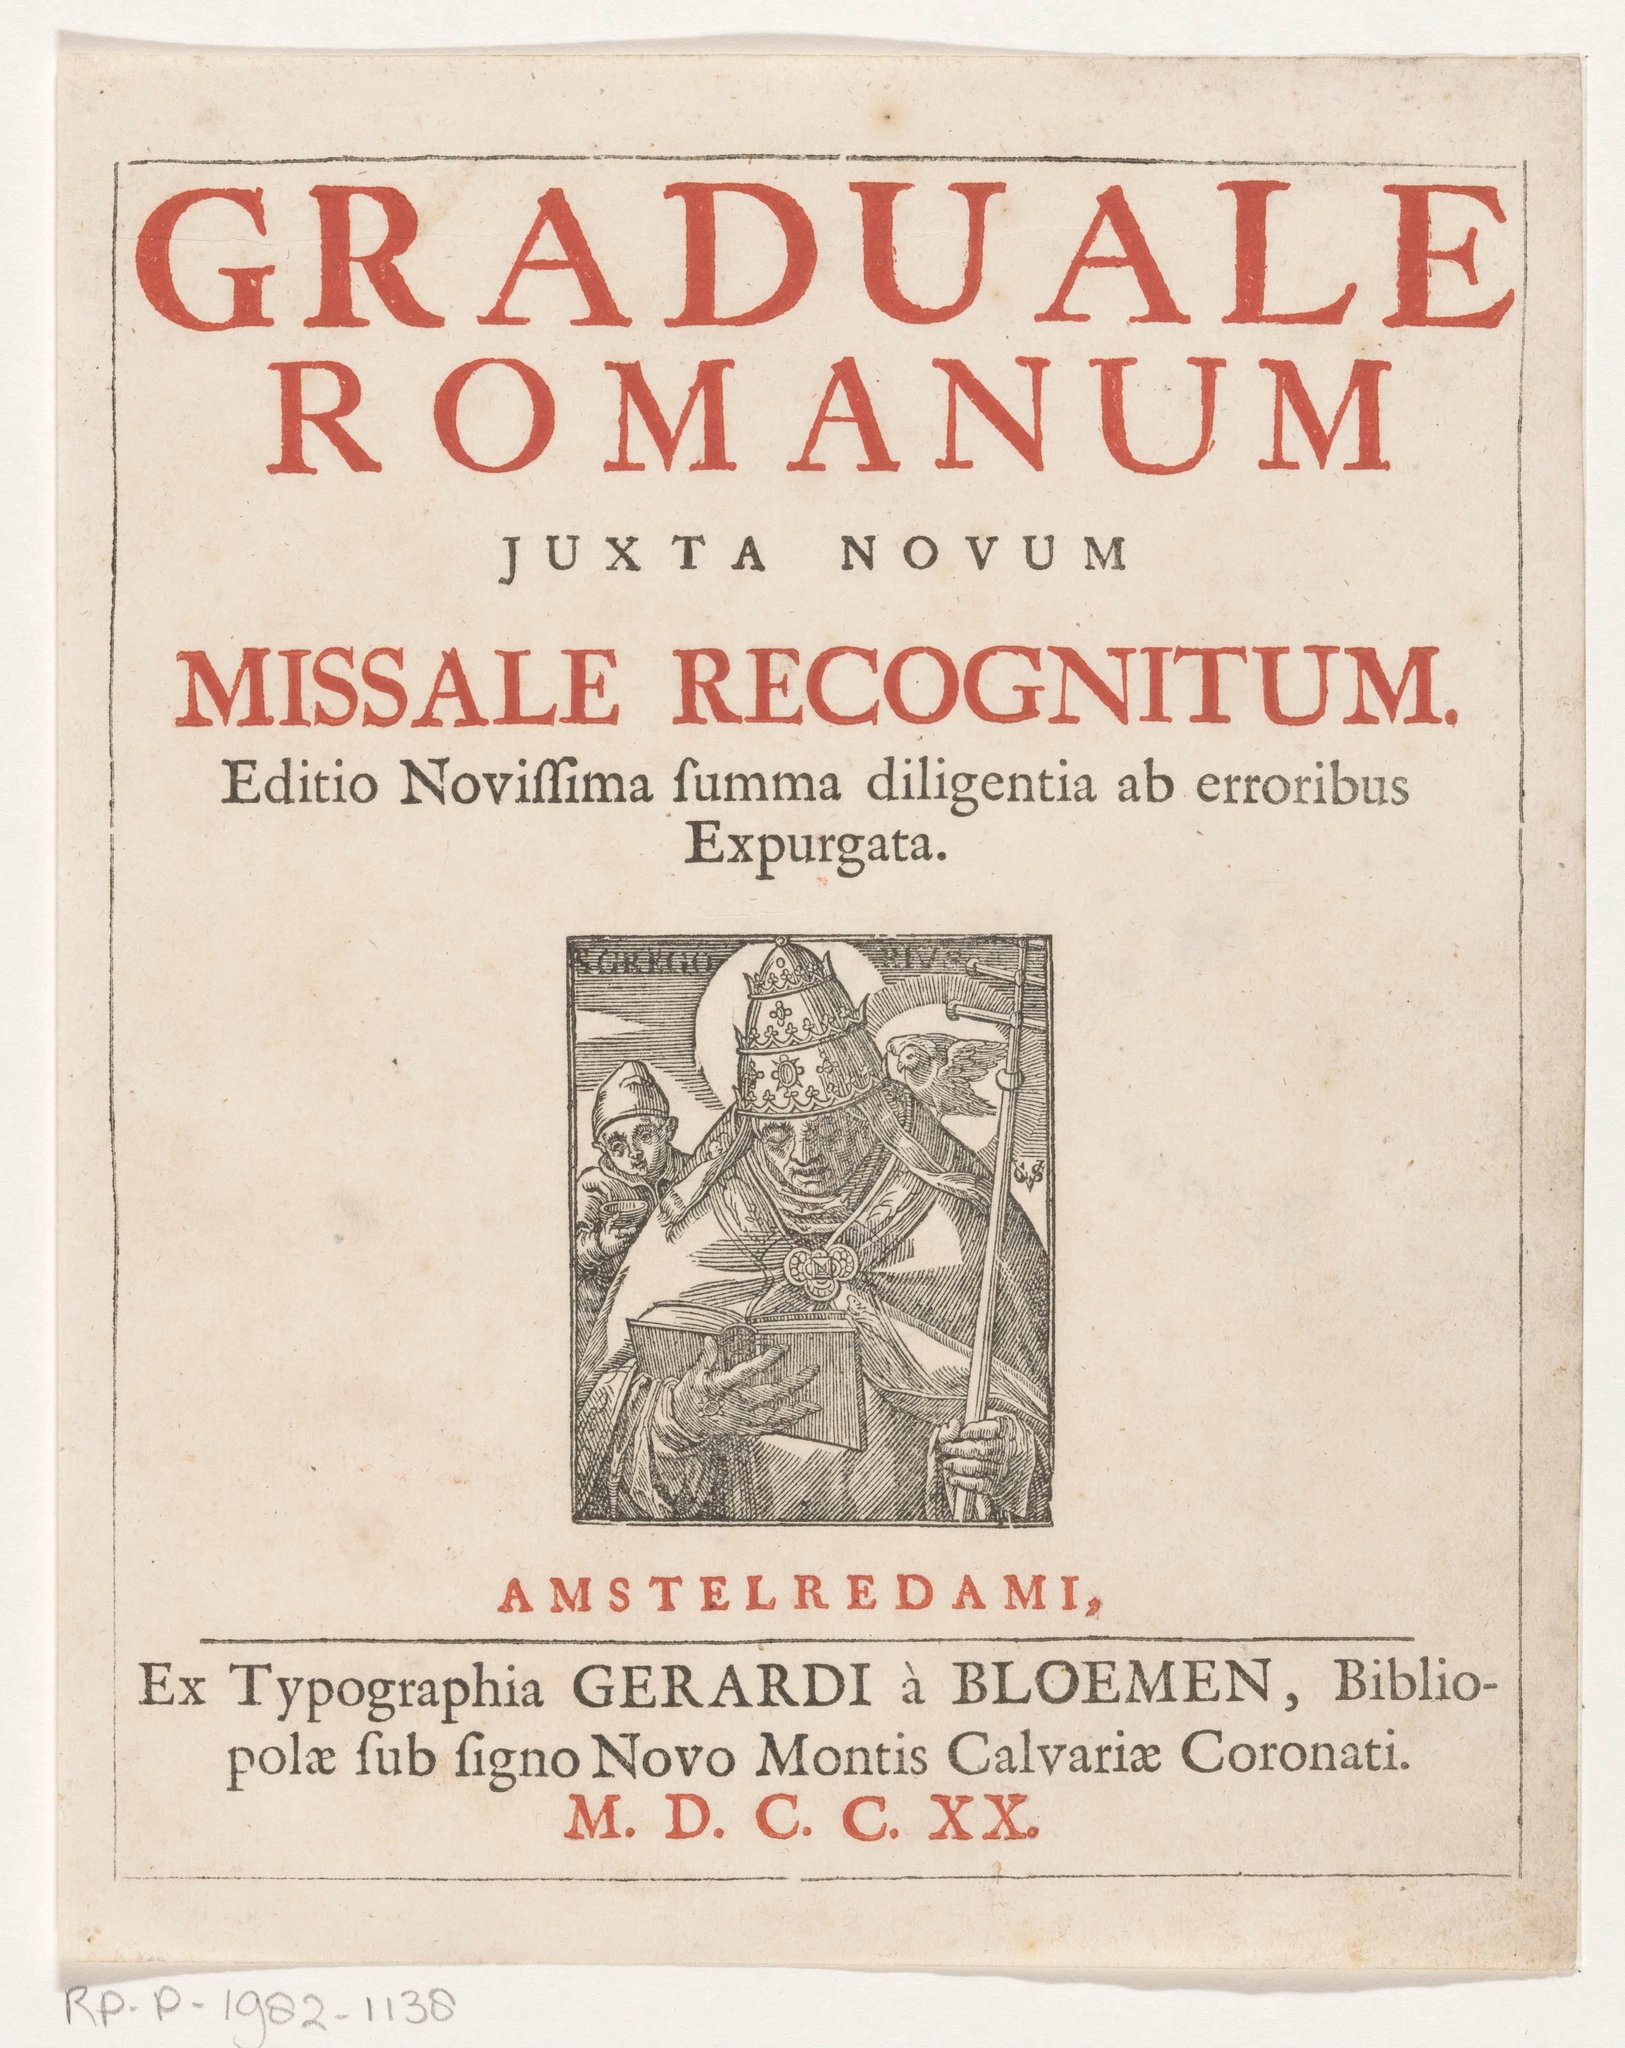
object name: print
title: Heilige Gregorius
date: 1720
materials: paper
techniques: letterpress printing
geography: amsterdam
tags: pope gregory the great; possible attributes: dove, emperor trajan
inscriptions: collector's mark: Lugt 2228, collector's mark: Lugt 2760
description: Heilige Gregorius met kruisstaf, pauselijke tiara en boek. Op zijn schouder zit een duif. Links in de achtergrond een jongen met beker.